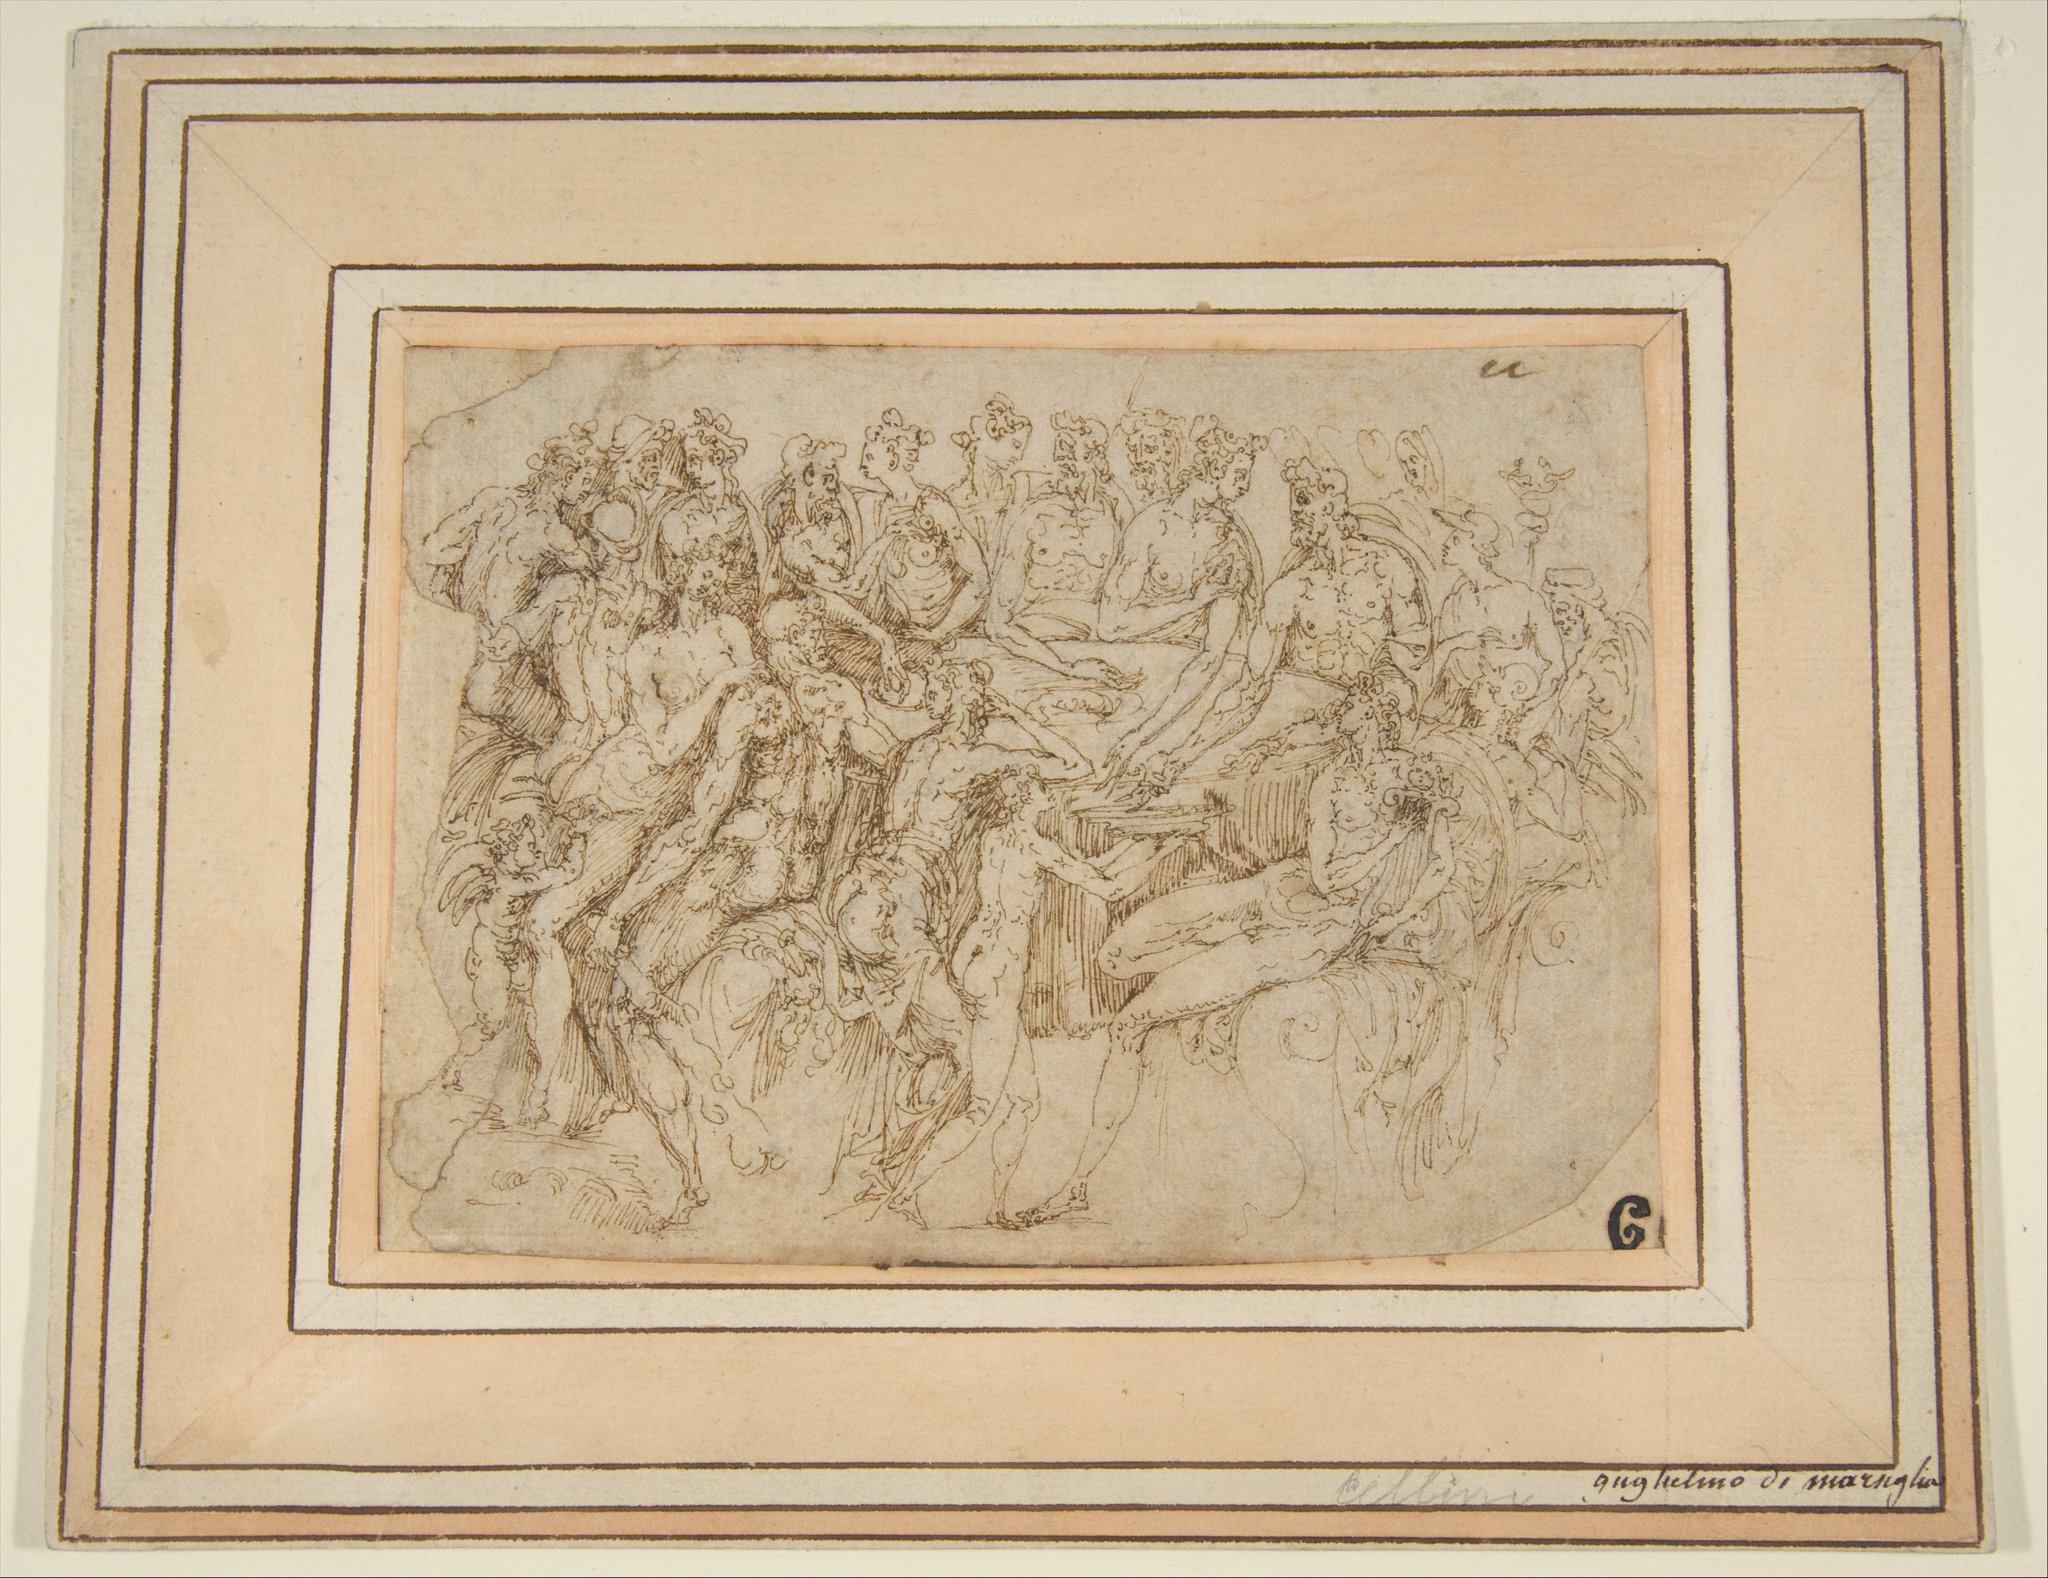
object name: drawing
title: The Banquet of the Gods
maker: guglielmo della porta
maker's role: artist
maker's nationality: italian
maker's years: 1500-1577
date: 1534-1577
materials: chalk, ink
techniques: pen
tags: male nudes,female nudes